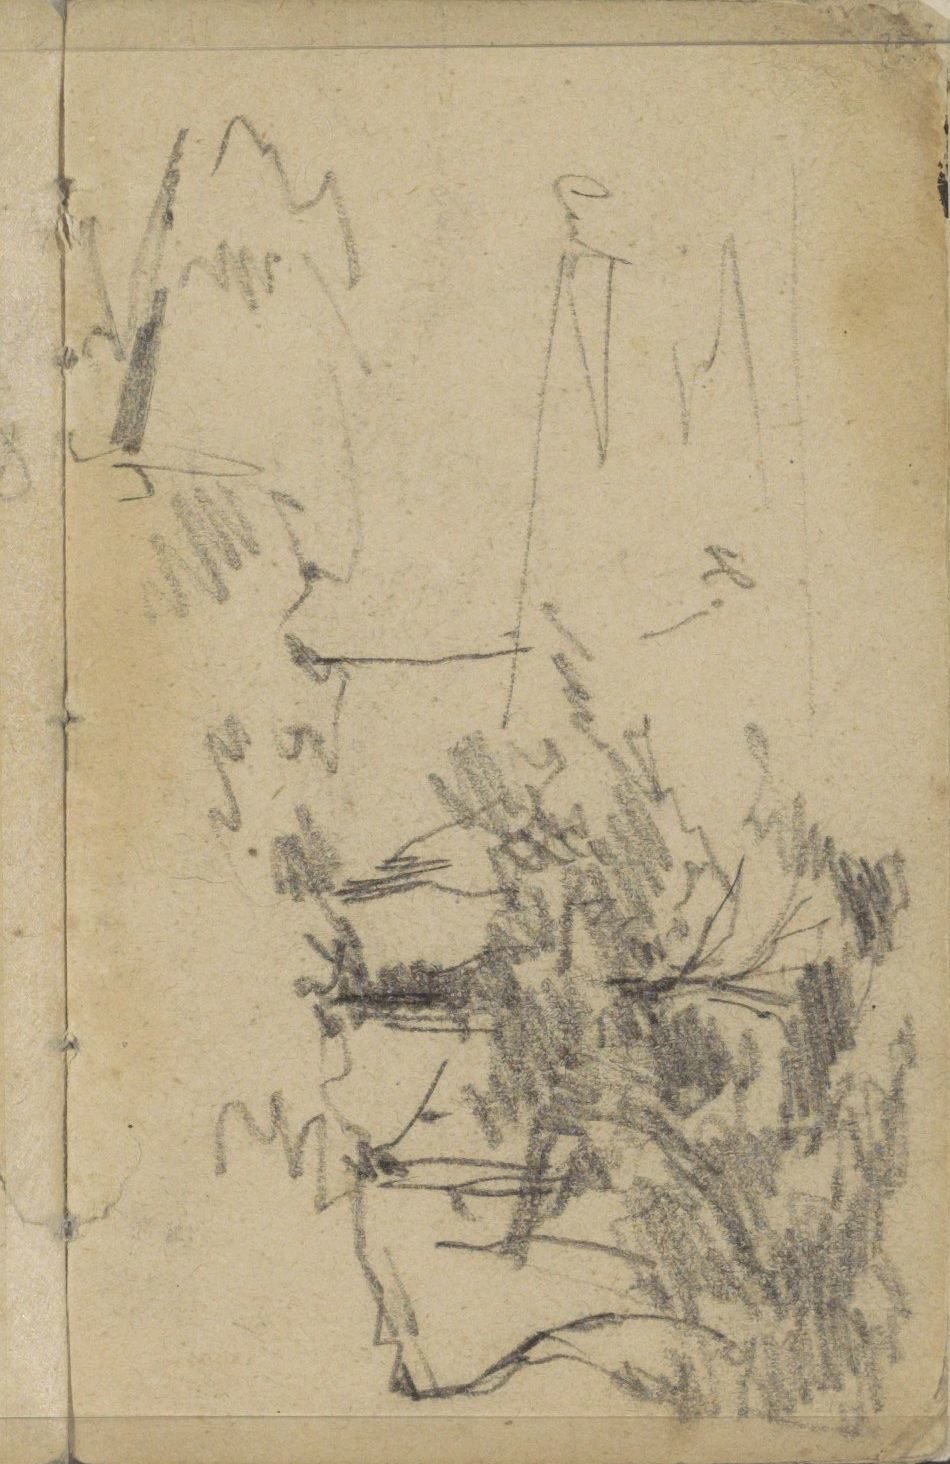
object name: sketchbook leaf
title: Landschap met bomen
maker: george hendrik breitner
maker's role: draughtsman, painter, print maker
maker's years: 1857-1923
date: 1881-1883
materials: chalk, paper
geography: south holland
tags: trees, landscapes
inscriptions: kleurnotitie, handgeschreven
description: Landschap met bomen. Pagina 75 uit een schetsboek met 43 bladen.